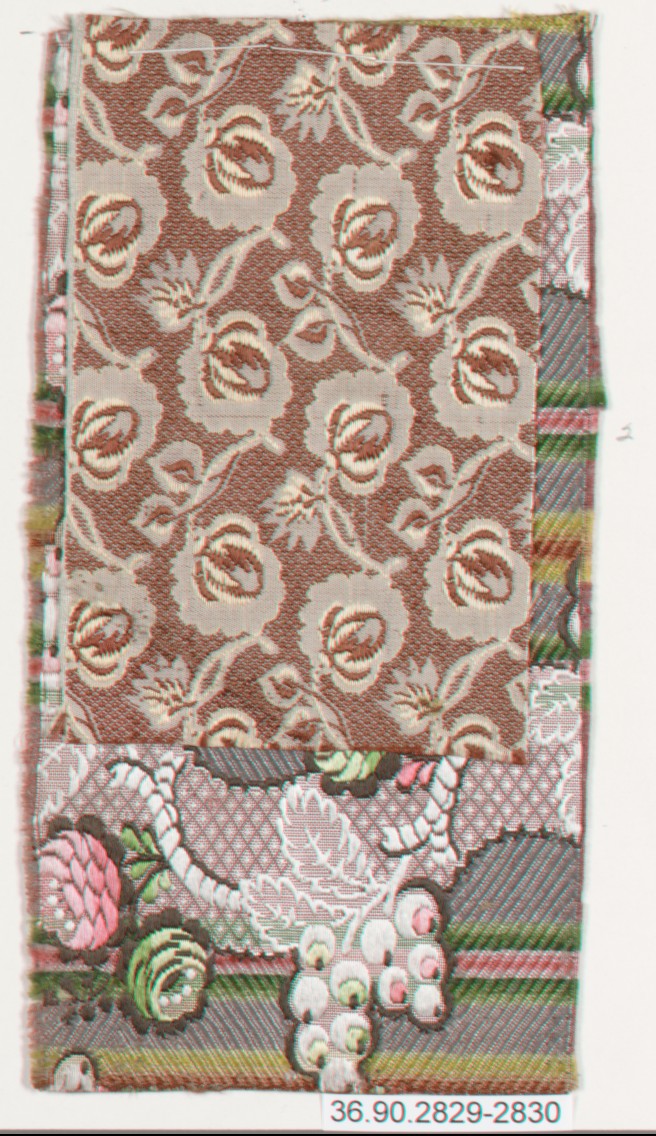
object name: piece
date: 1801-1900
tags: flowers